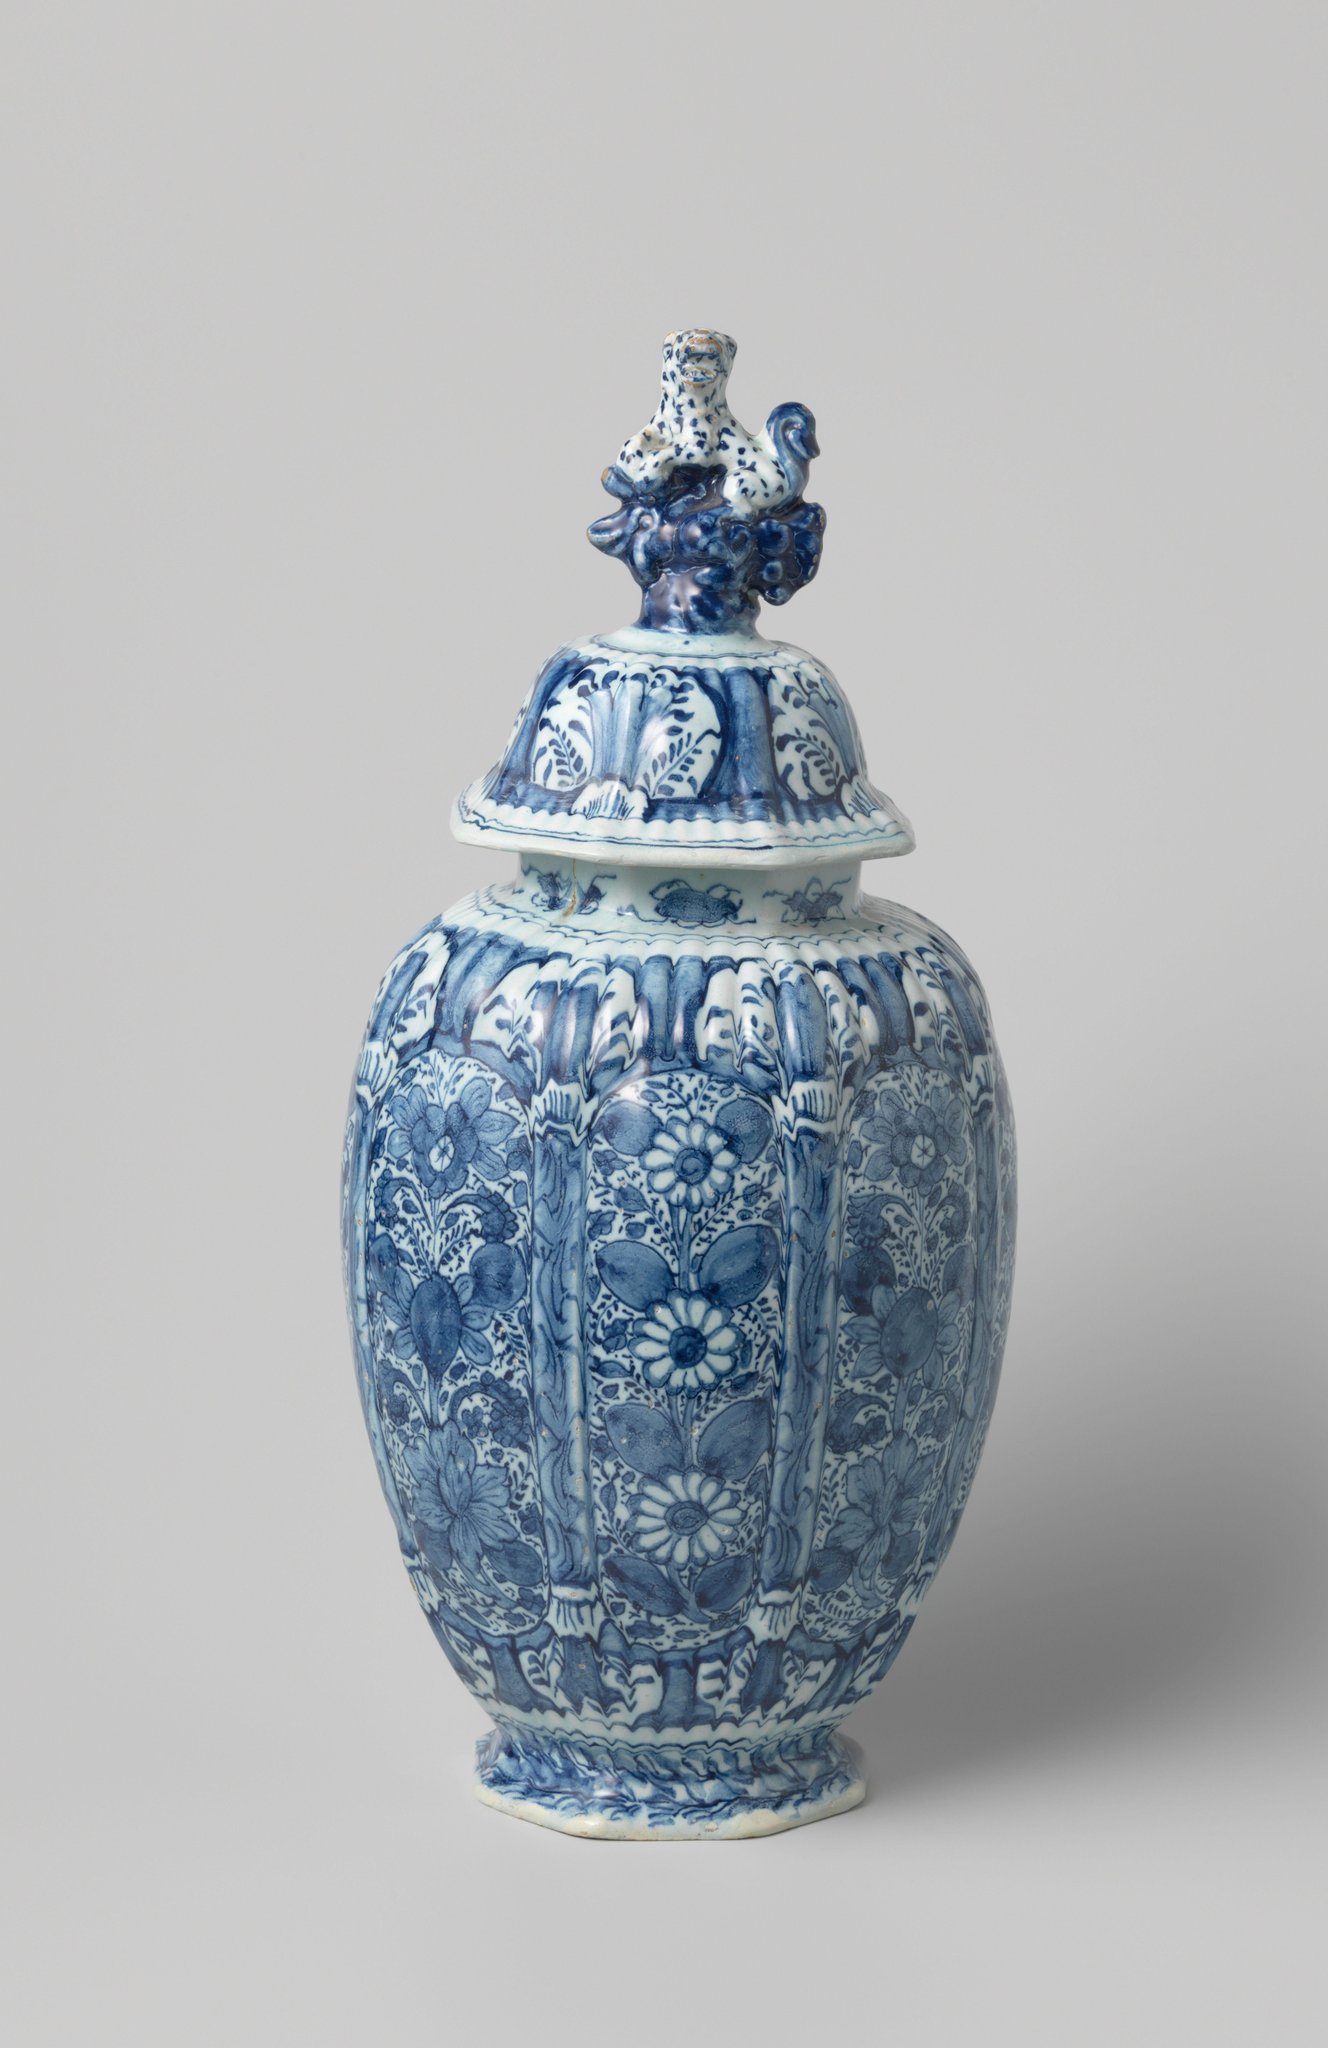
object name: kaststel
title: Deksel van vaas van faience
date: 1740-1780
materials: faience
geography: delft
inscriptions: mark: ‘LPK’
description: Deksel van vaas van faience. Blauw beschilderd met bloemendecoraties. De vaas is onderdeel van een kaststel.